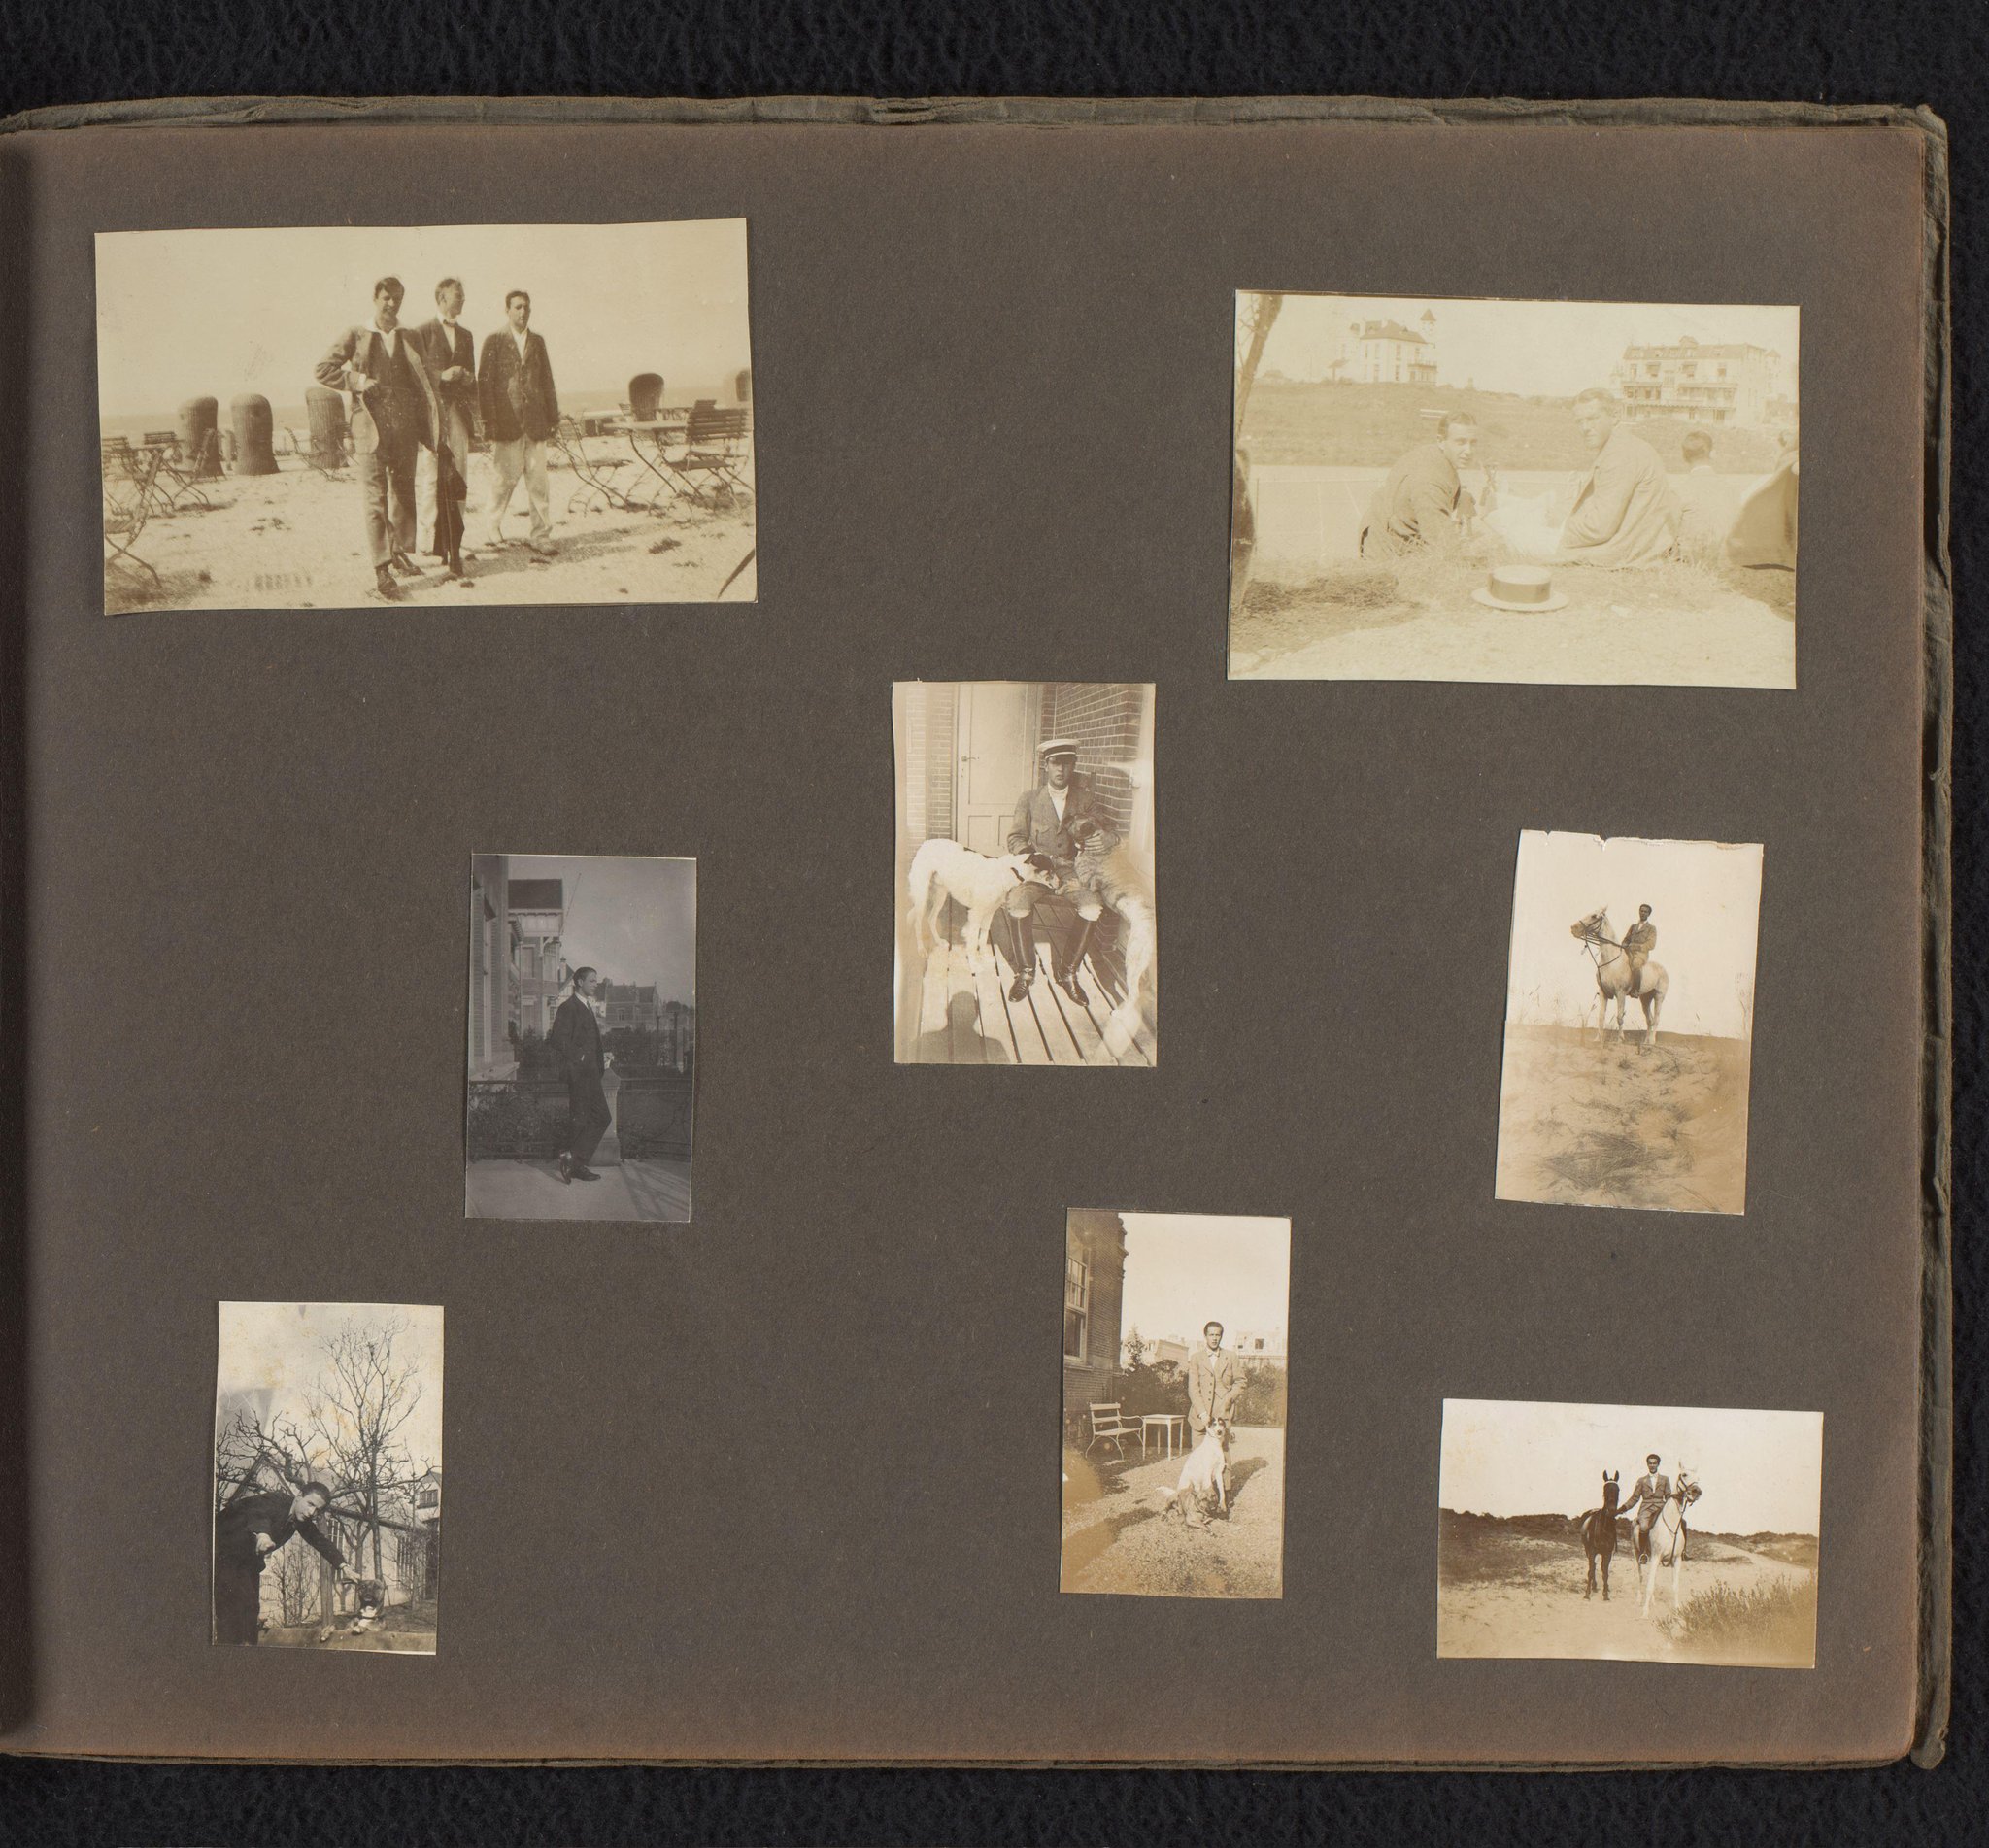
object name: photograph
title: Drie jonge mannen op een strand, te paard in duinen, en in een tuin met twee honden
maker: Anonymous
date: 1913-1914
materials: paper, cardboard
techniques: gelatin silver print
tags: beach (as place of recreation), recreation in the dunes, anonymous historical person portrayed, horse, dog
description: Deze foto's zijn onderdeel van een album.